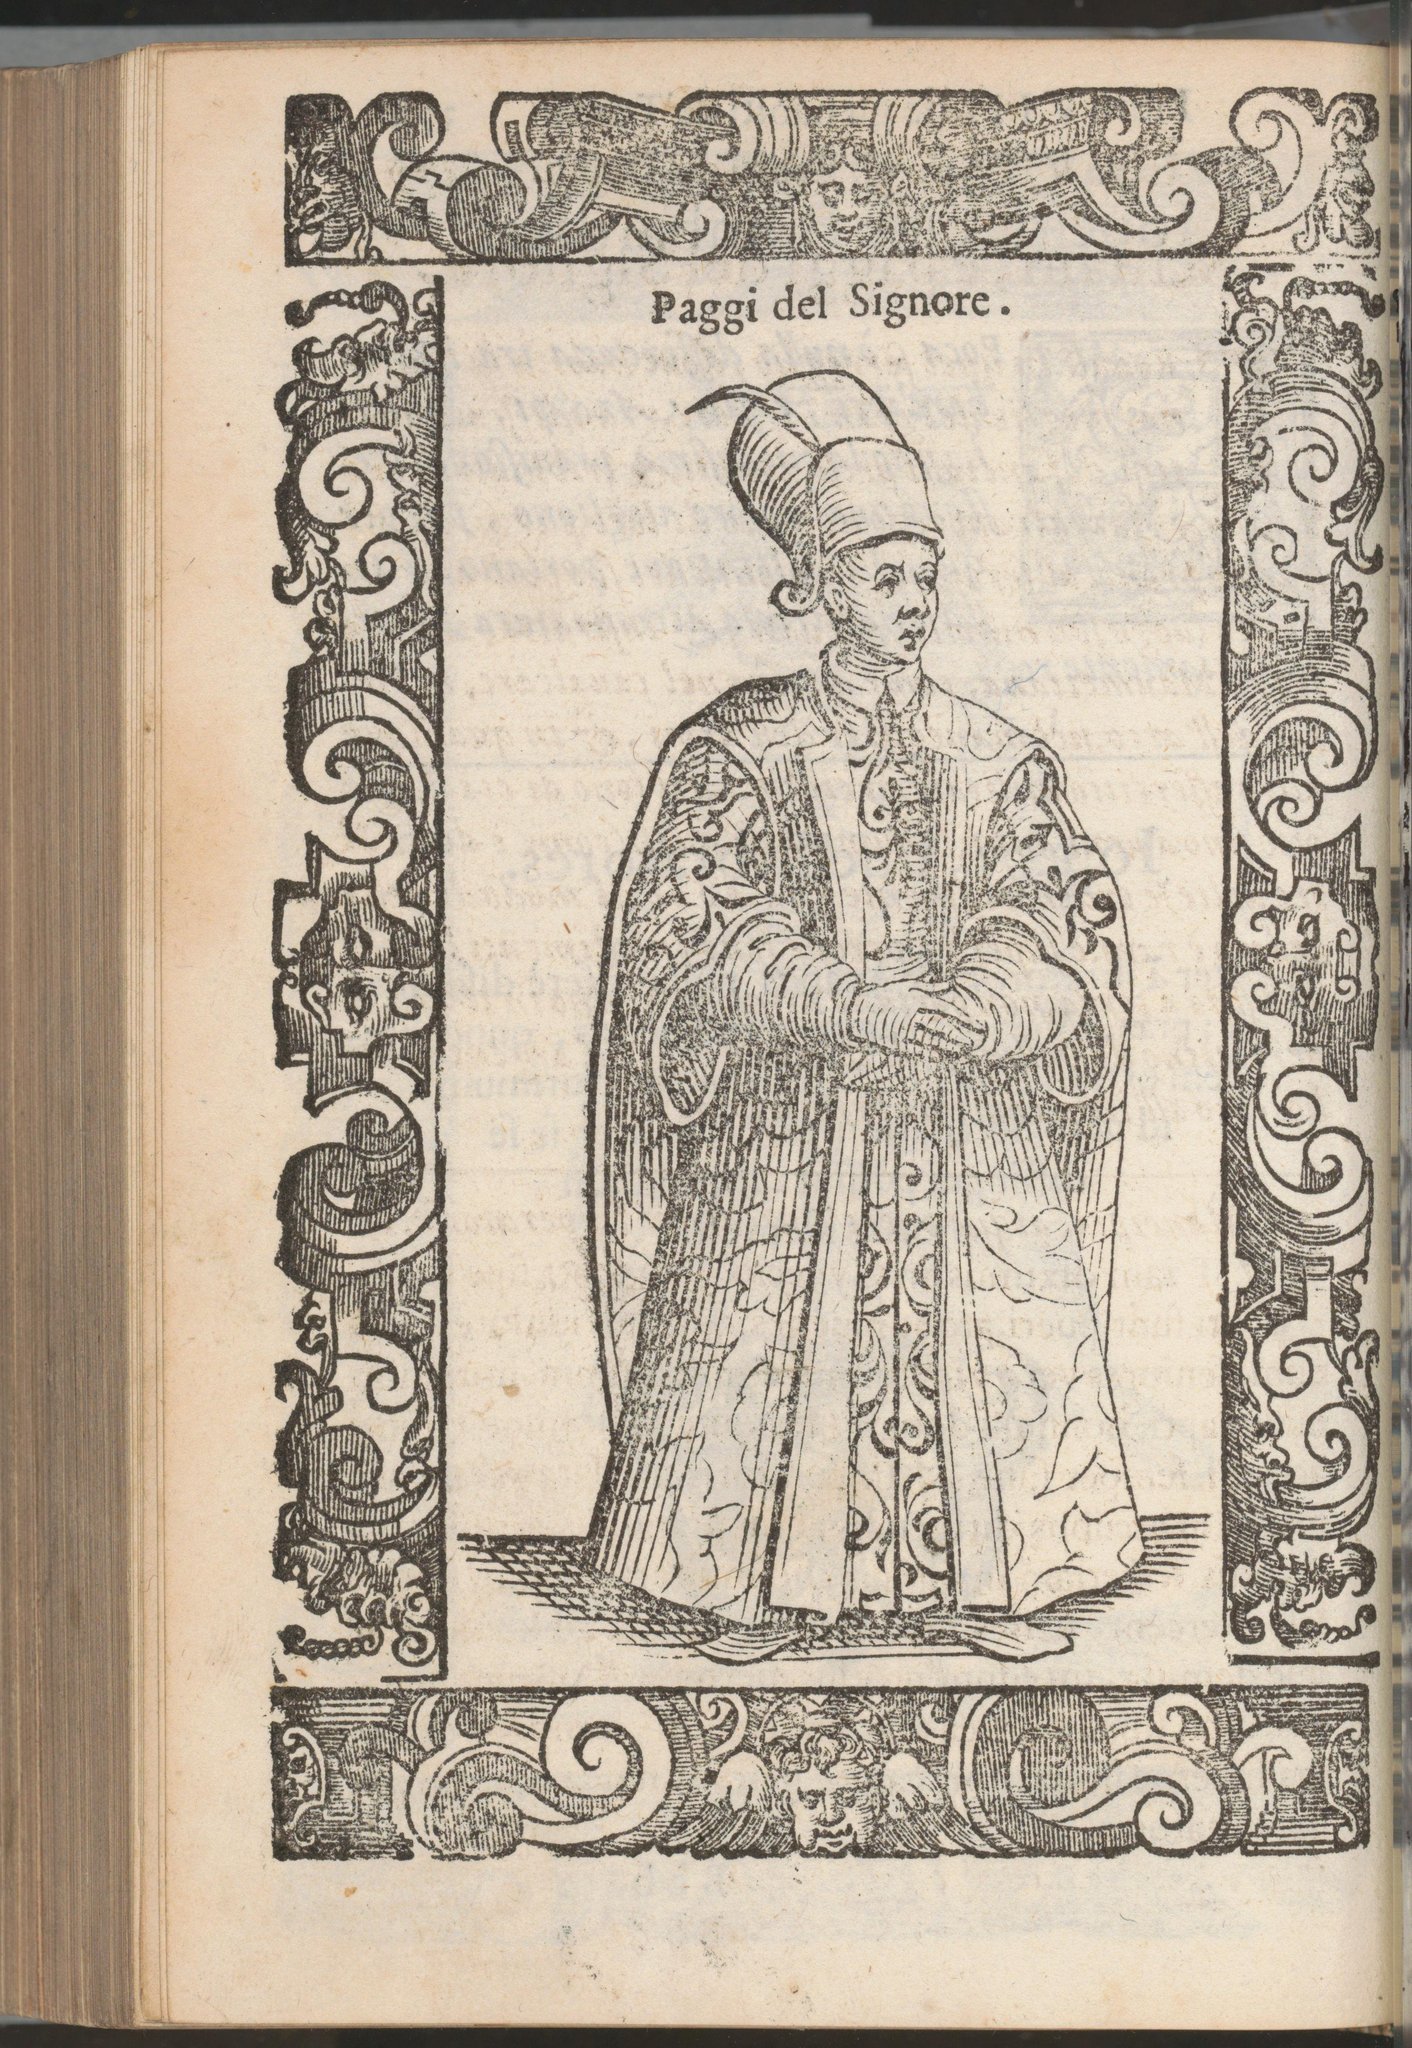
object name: costume print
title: Habiti antichi, et moderni di tutto il mondo...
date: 1598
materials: paper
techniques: woodcut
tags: fashion plates